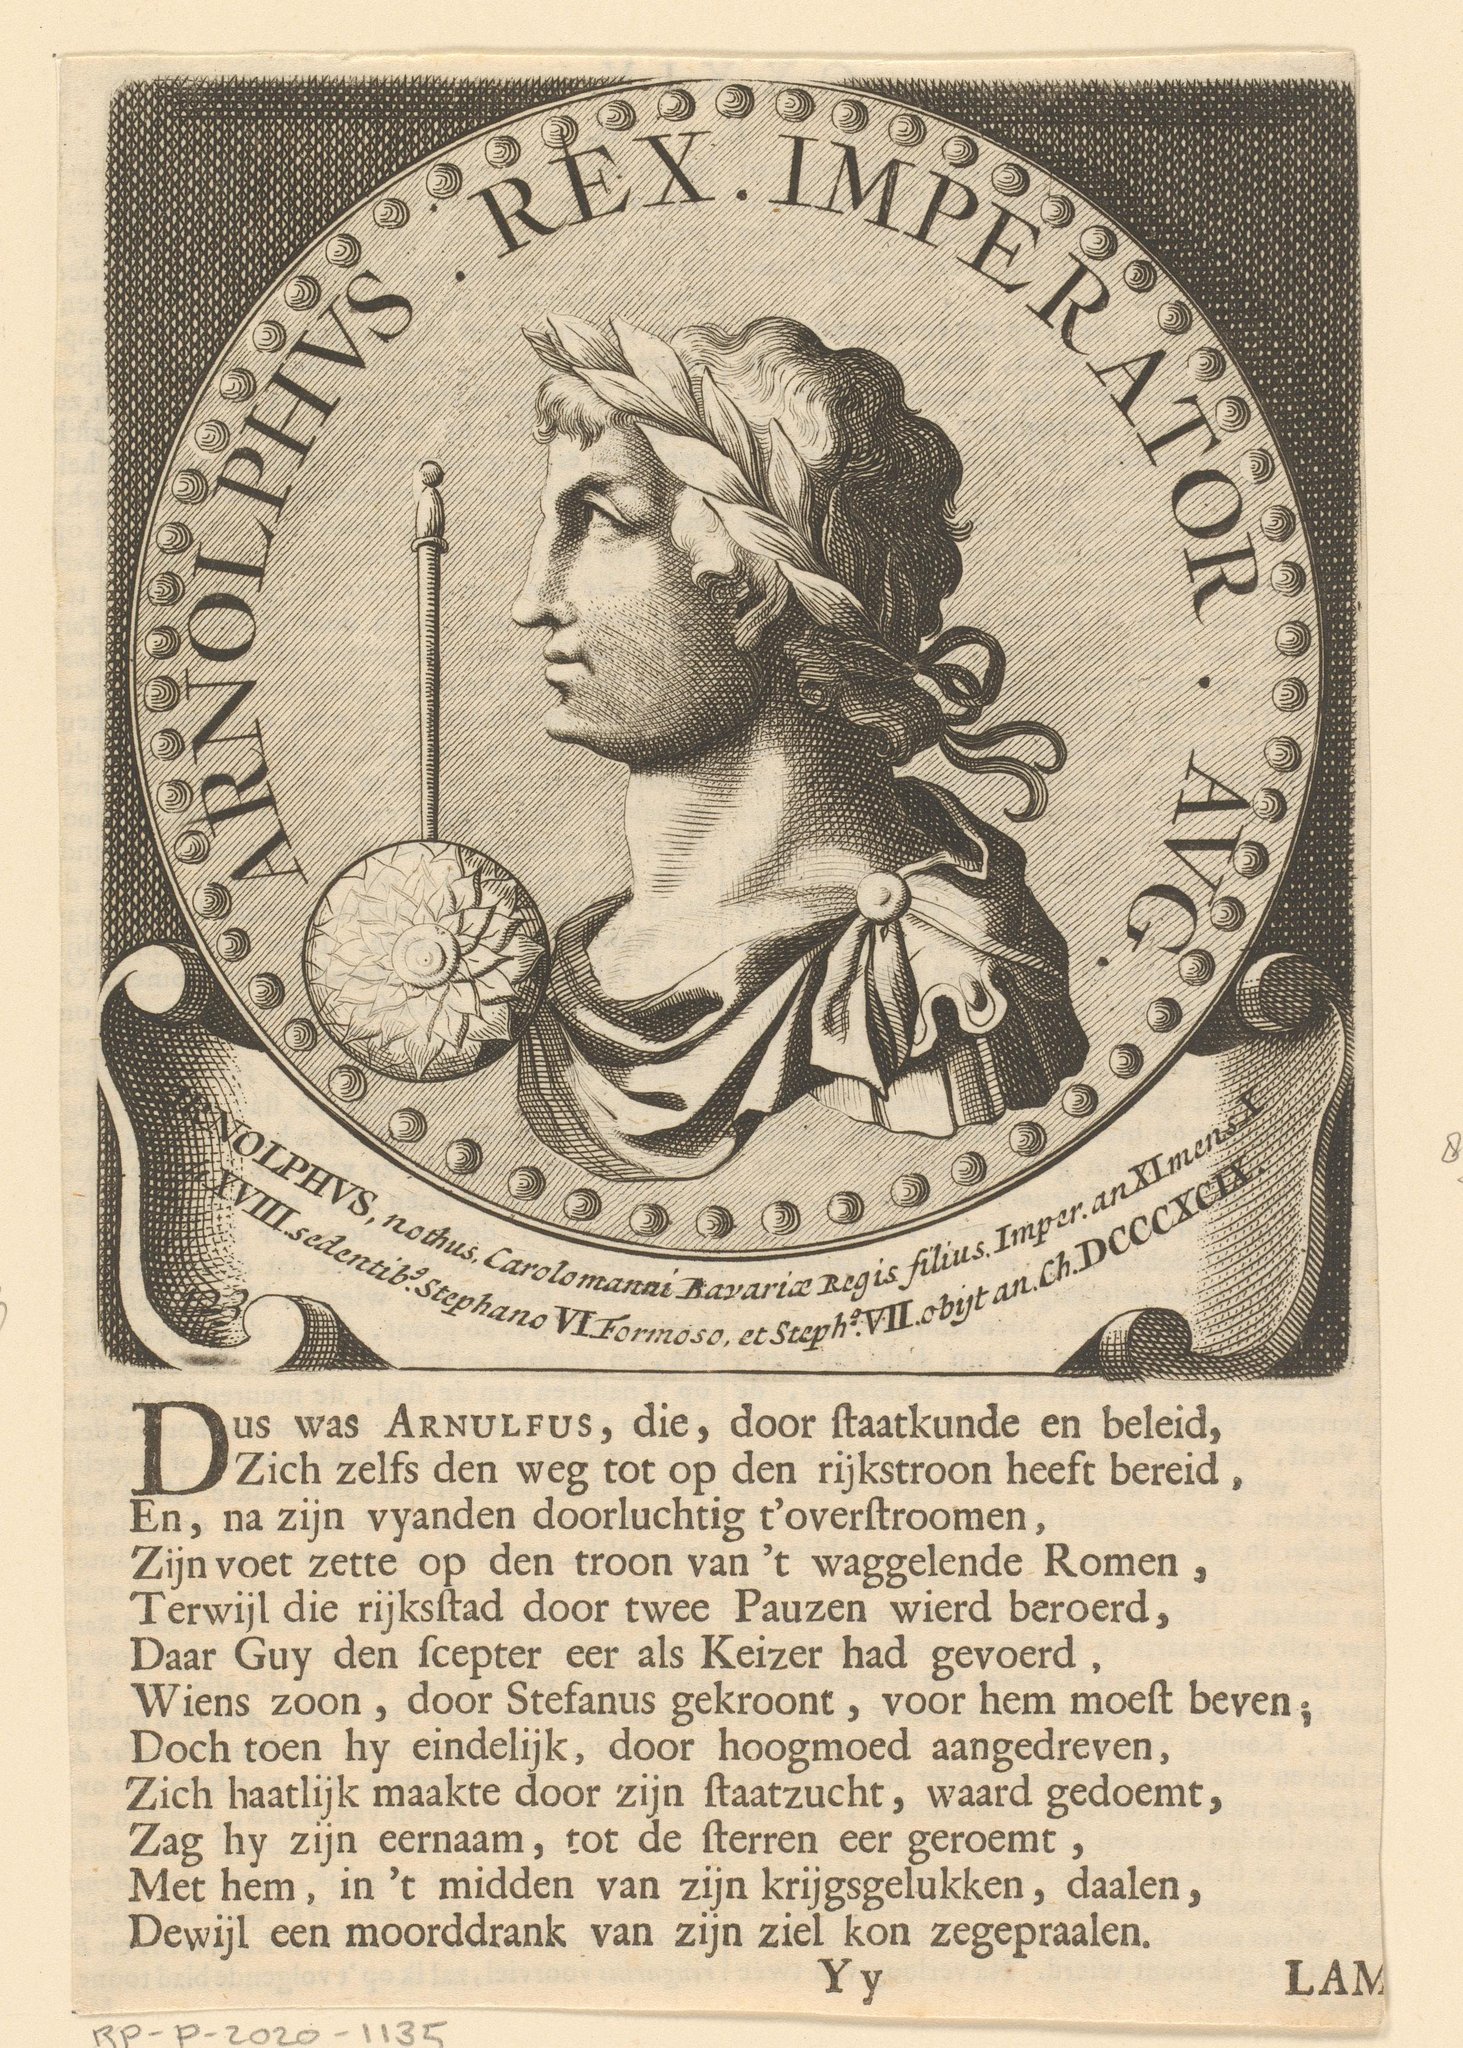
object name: print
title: Arnolphus, nothus Carolomanni Bavariae regis (...)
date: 1697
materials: paper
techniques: engraving, etching, letterpress printing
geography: utrecht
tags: historical persons, emperor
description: Prent uit: Bogaert, Abraham. De Roomsche monarchy, vertoont in de muntbeelden der westersche en oostersche keizeren (...). Utrecht: François Halma en Willem van de Water, 1697, p. 353. Eerste staat verschenen in een grotere prent met twaalf portretten, gedateerd 1695.